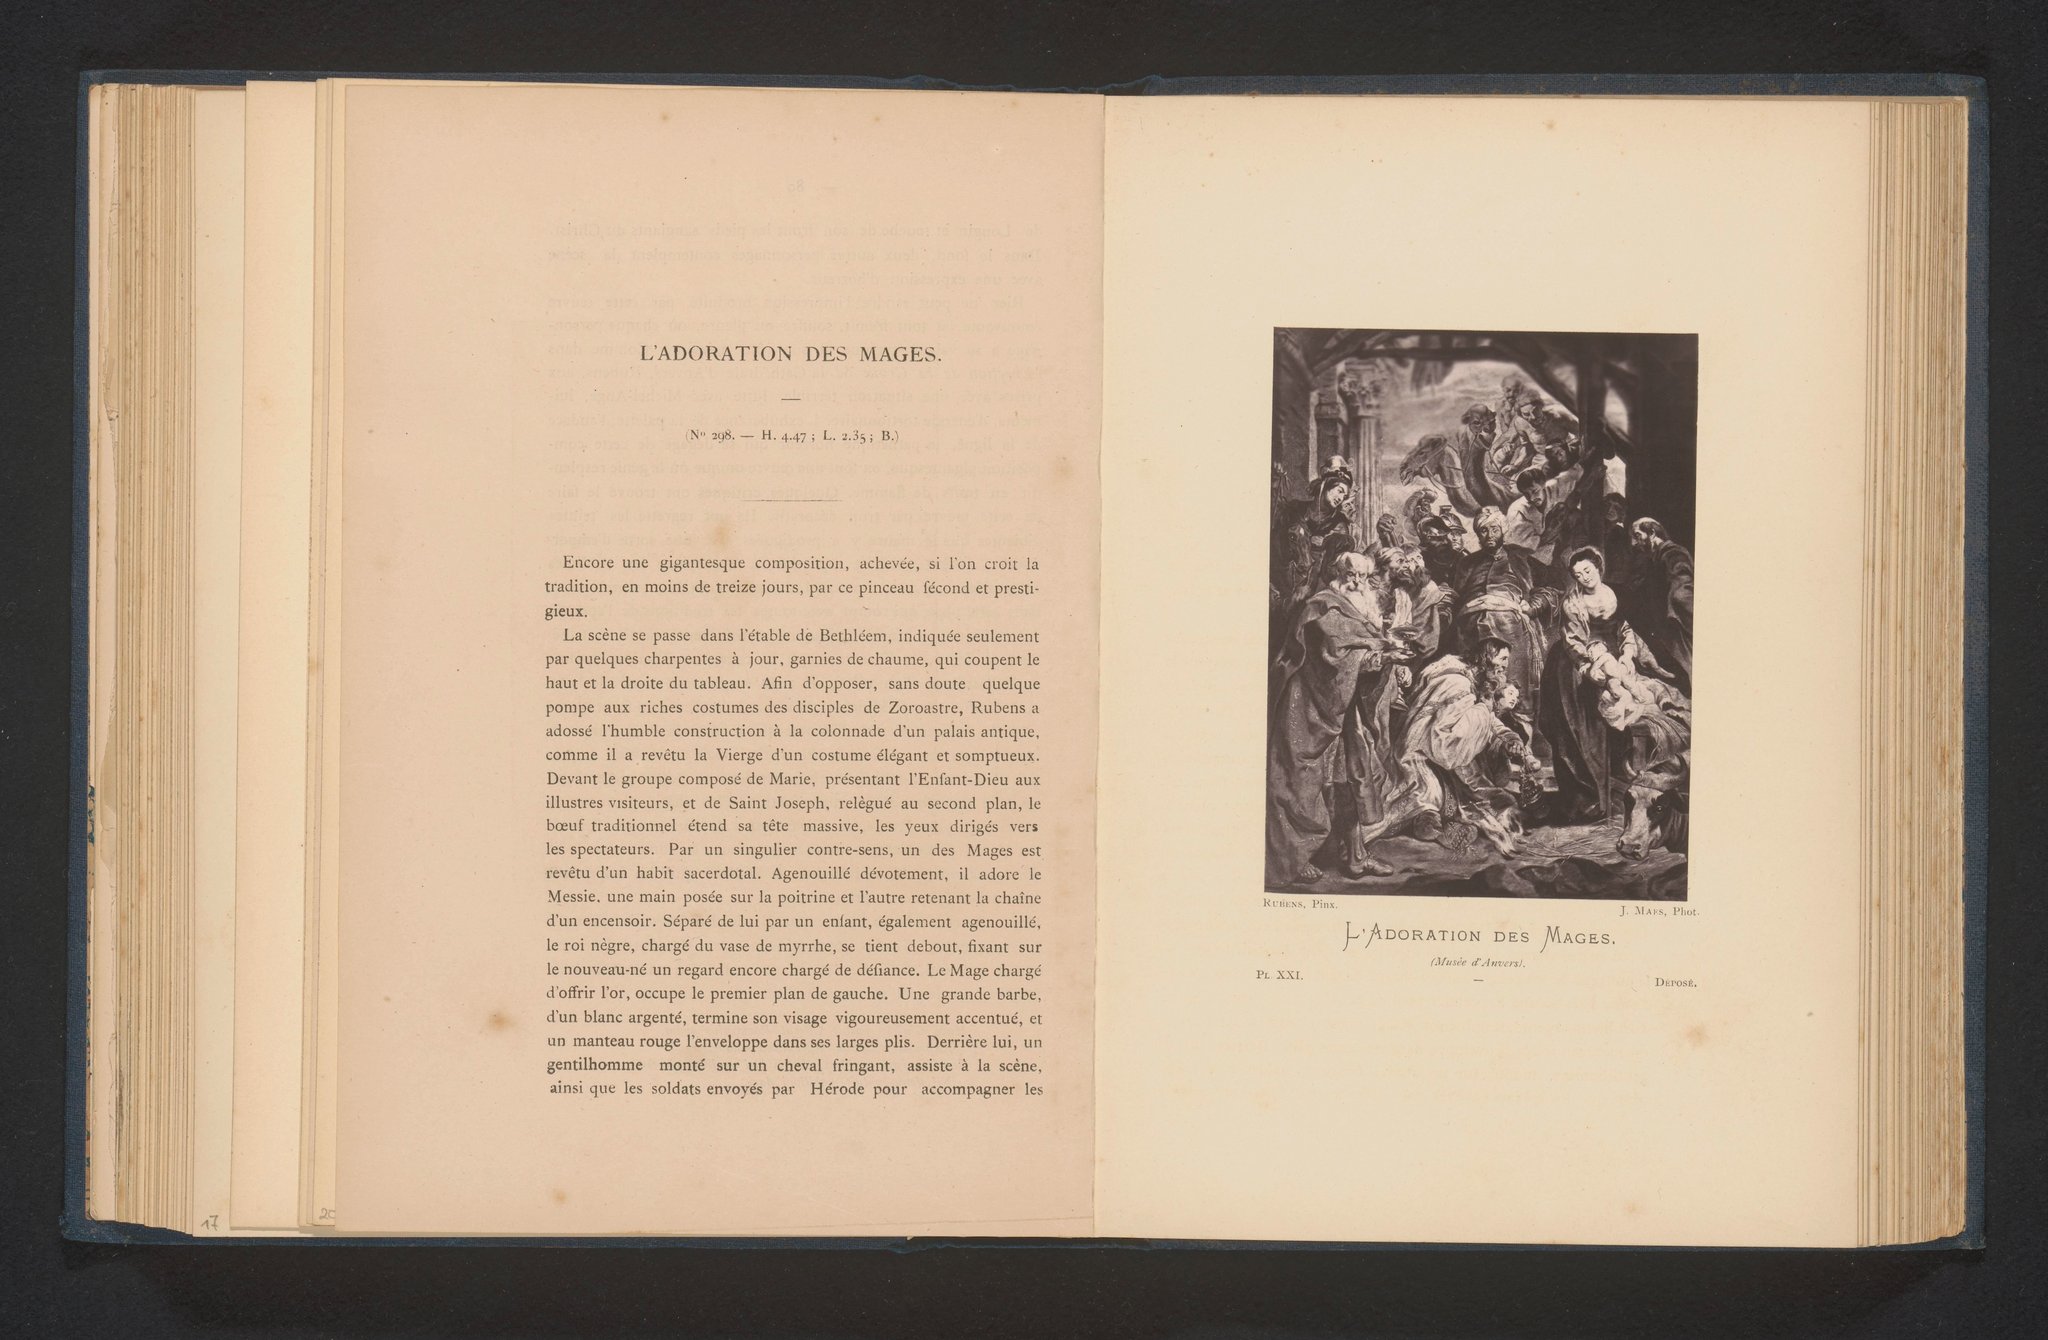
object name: photomechanical print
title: L'Adoration des Mages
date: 1872-1877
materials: paper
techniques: woodburytype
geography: antwerp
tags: adoration of the kings: the wise men present their gifts to the christ-child (gold, frankincense and myrrh) (+ donor(s), supplicant(s), whether or not with patron saint(s))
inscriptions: inscription: ‘(Musée d'Anvers)/ Pl. XXI. Déposé.’